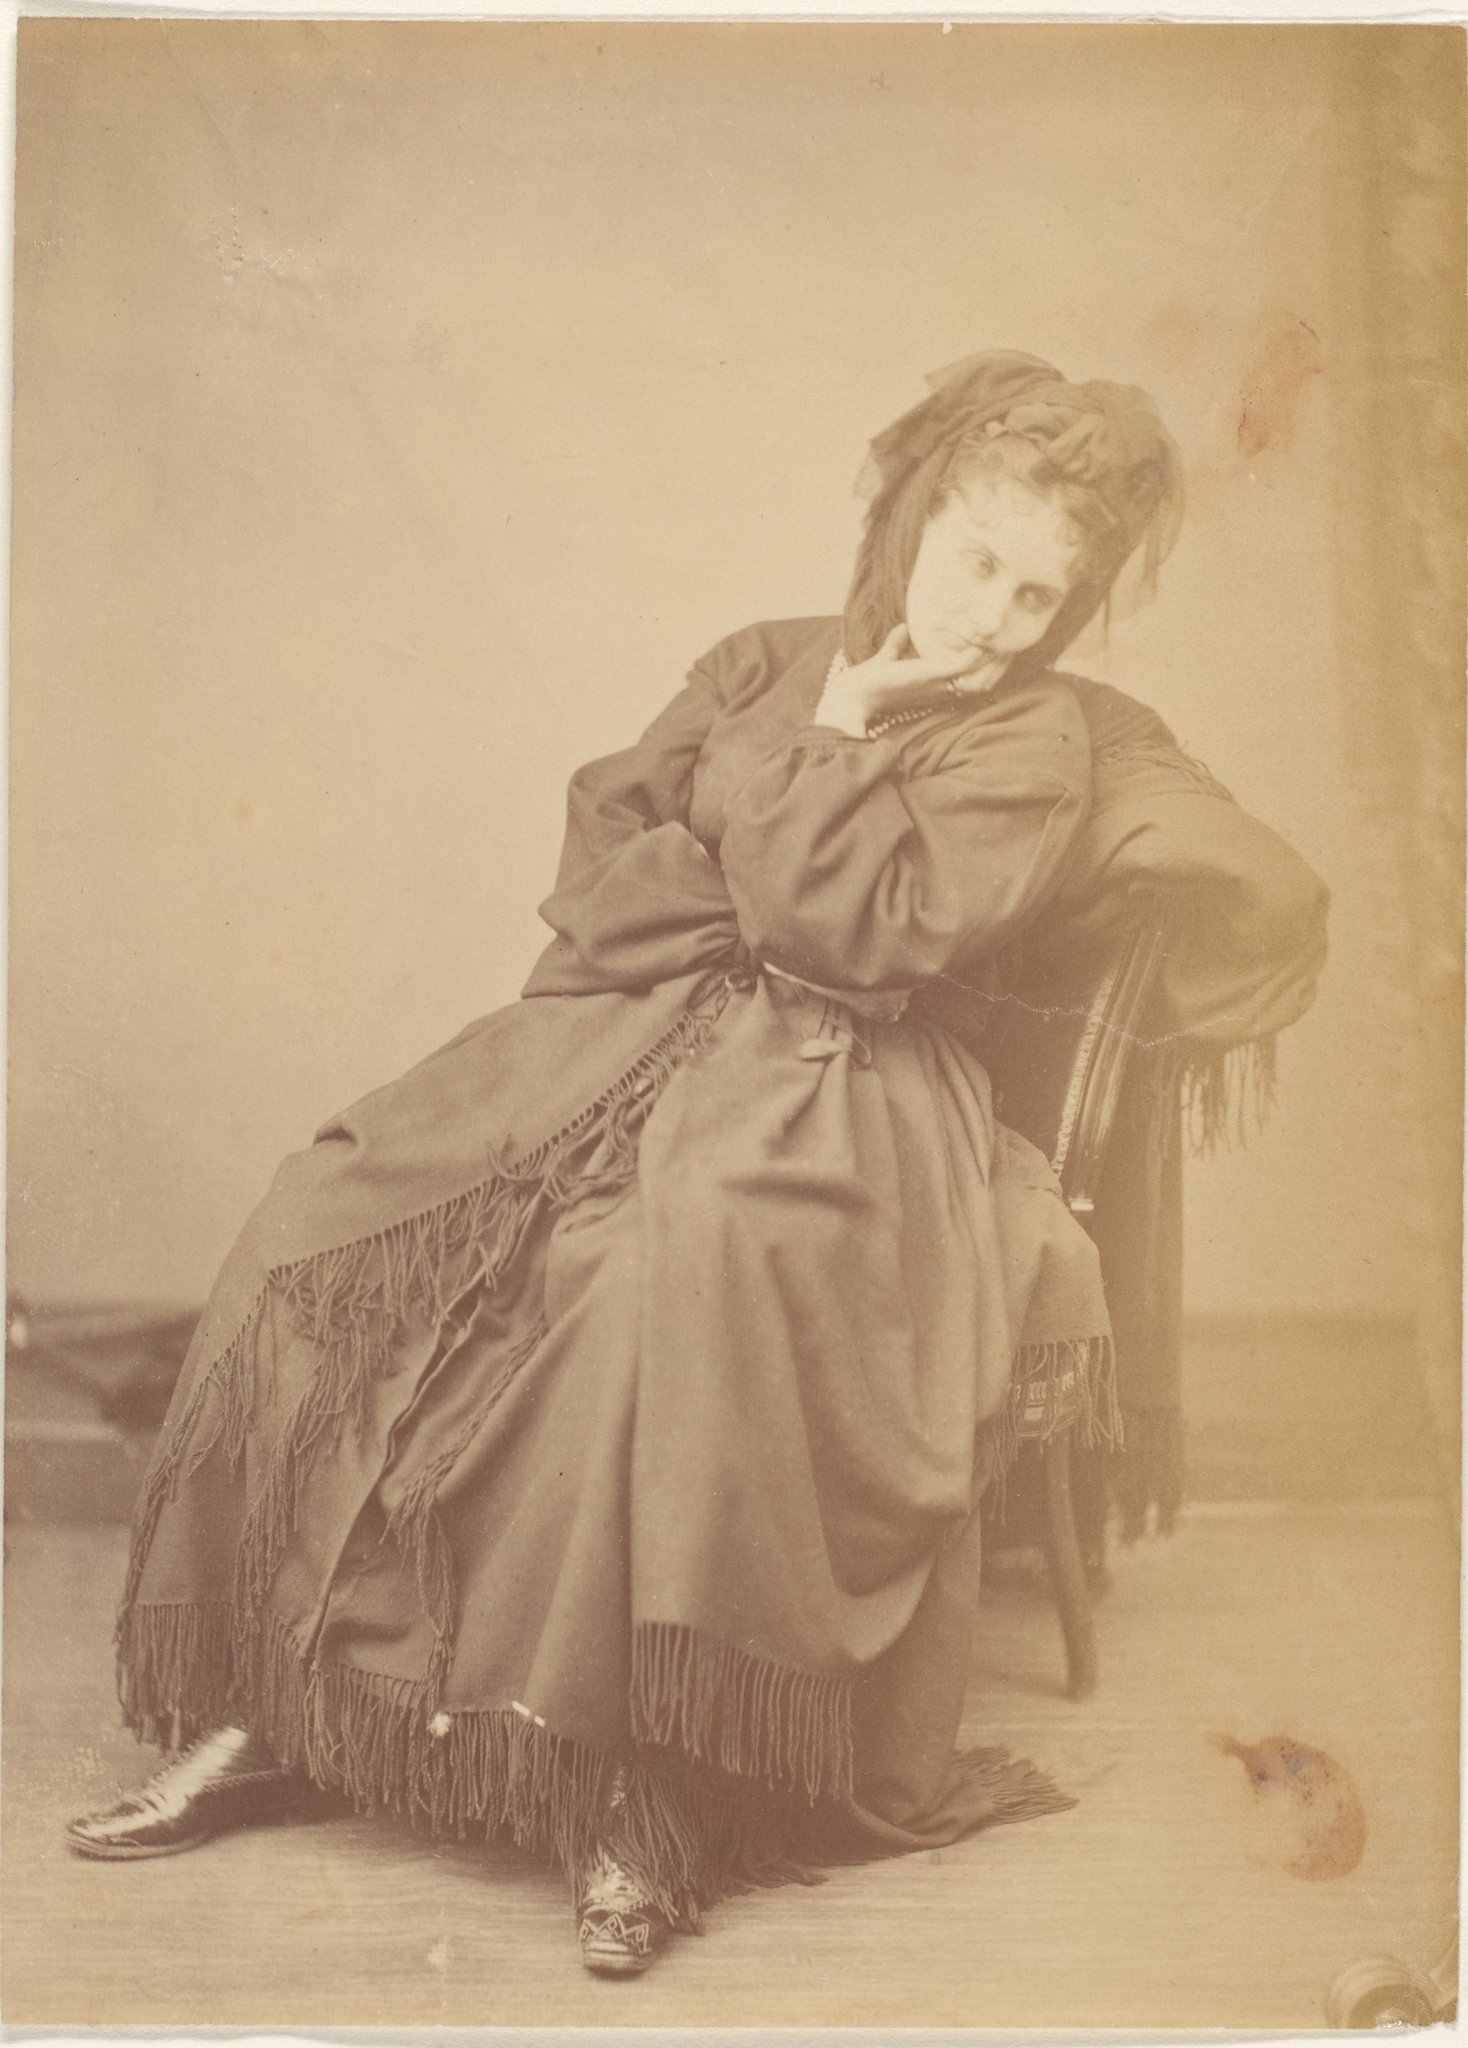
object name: photograph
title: Sèriè à la Ristori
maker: pierre-louis pierson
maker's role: artist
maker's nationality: french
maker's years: 1822-1913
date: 1860-1869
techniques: albumen silver print, glass negative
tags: portraits,women